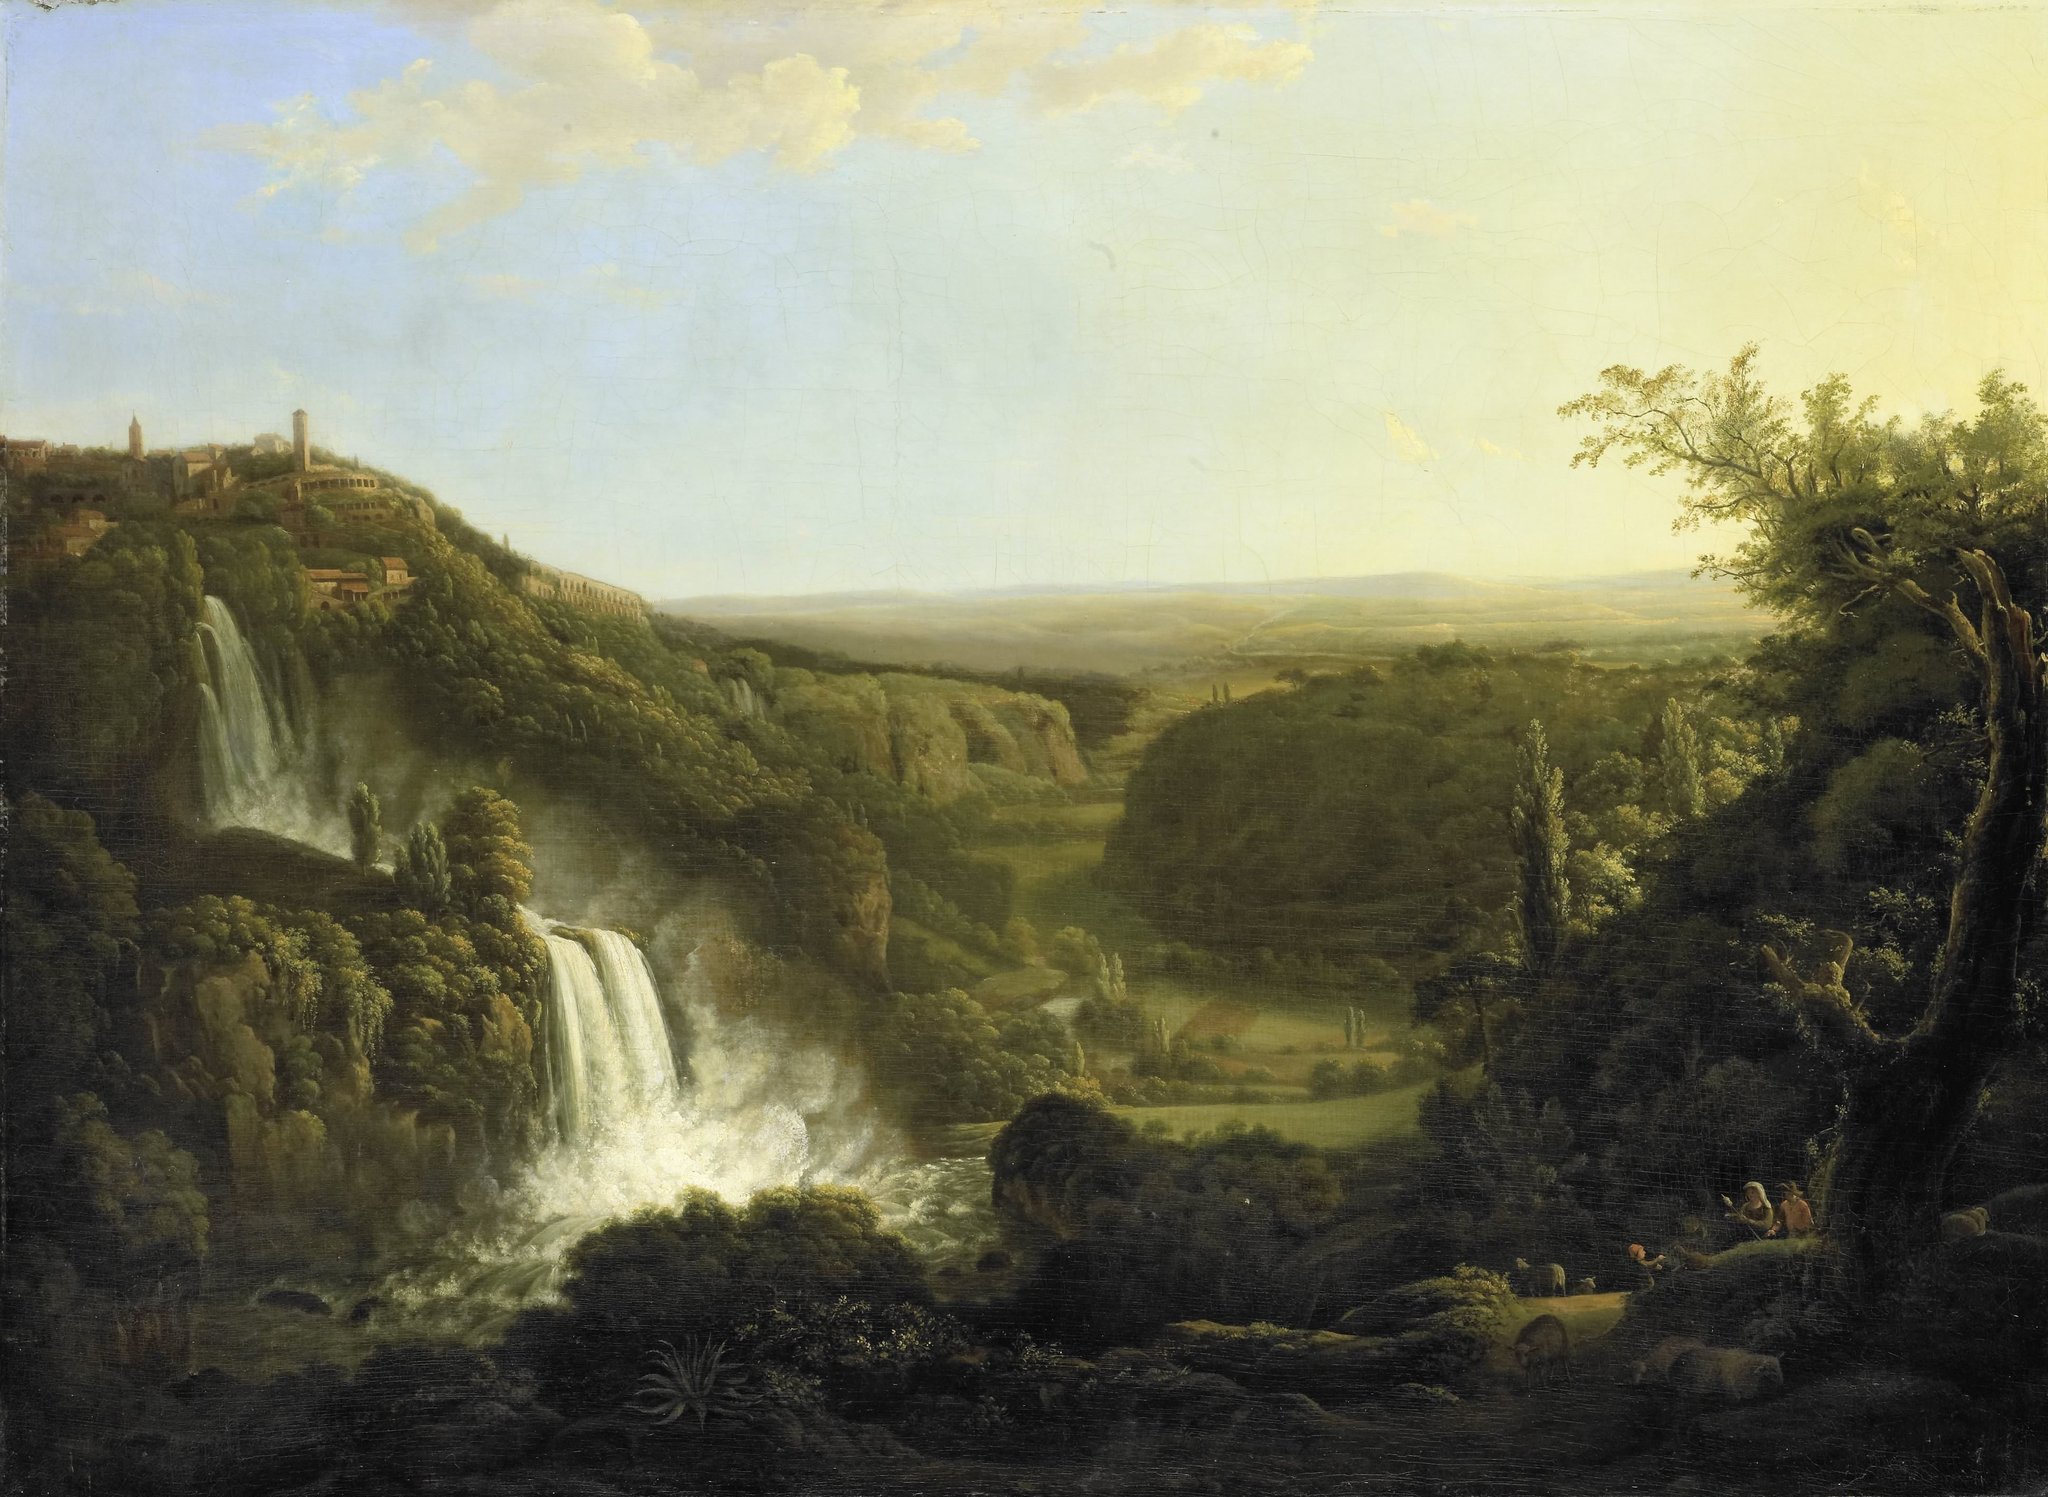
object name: painting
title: The Anio Valley with the Waterfalls of Tivoli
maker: cornelis apostool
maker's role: draughtsman, print maker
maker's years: 1762-1844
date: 1800-1825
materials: canvas, oil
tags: waterfall, tivoli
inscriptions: signature: ‘C. Apostool ft’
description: Italiaans landschap met het dal van de Anio en de watervallen van Tivoli.